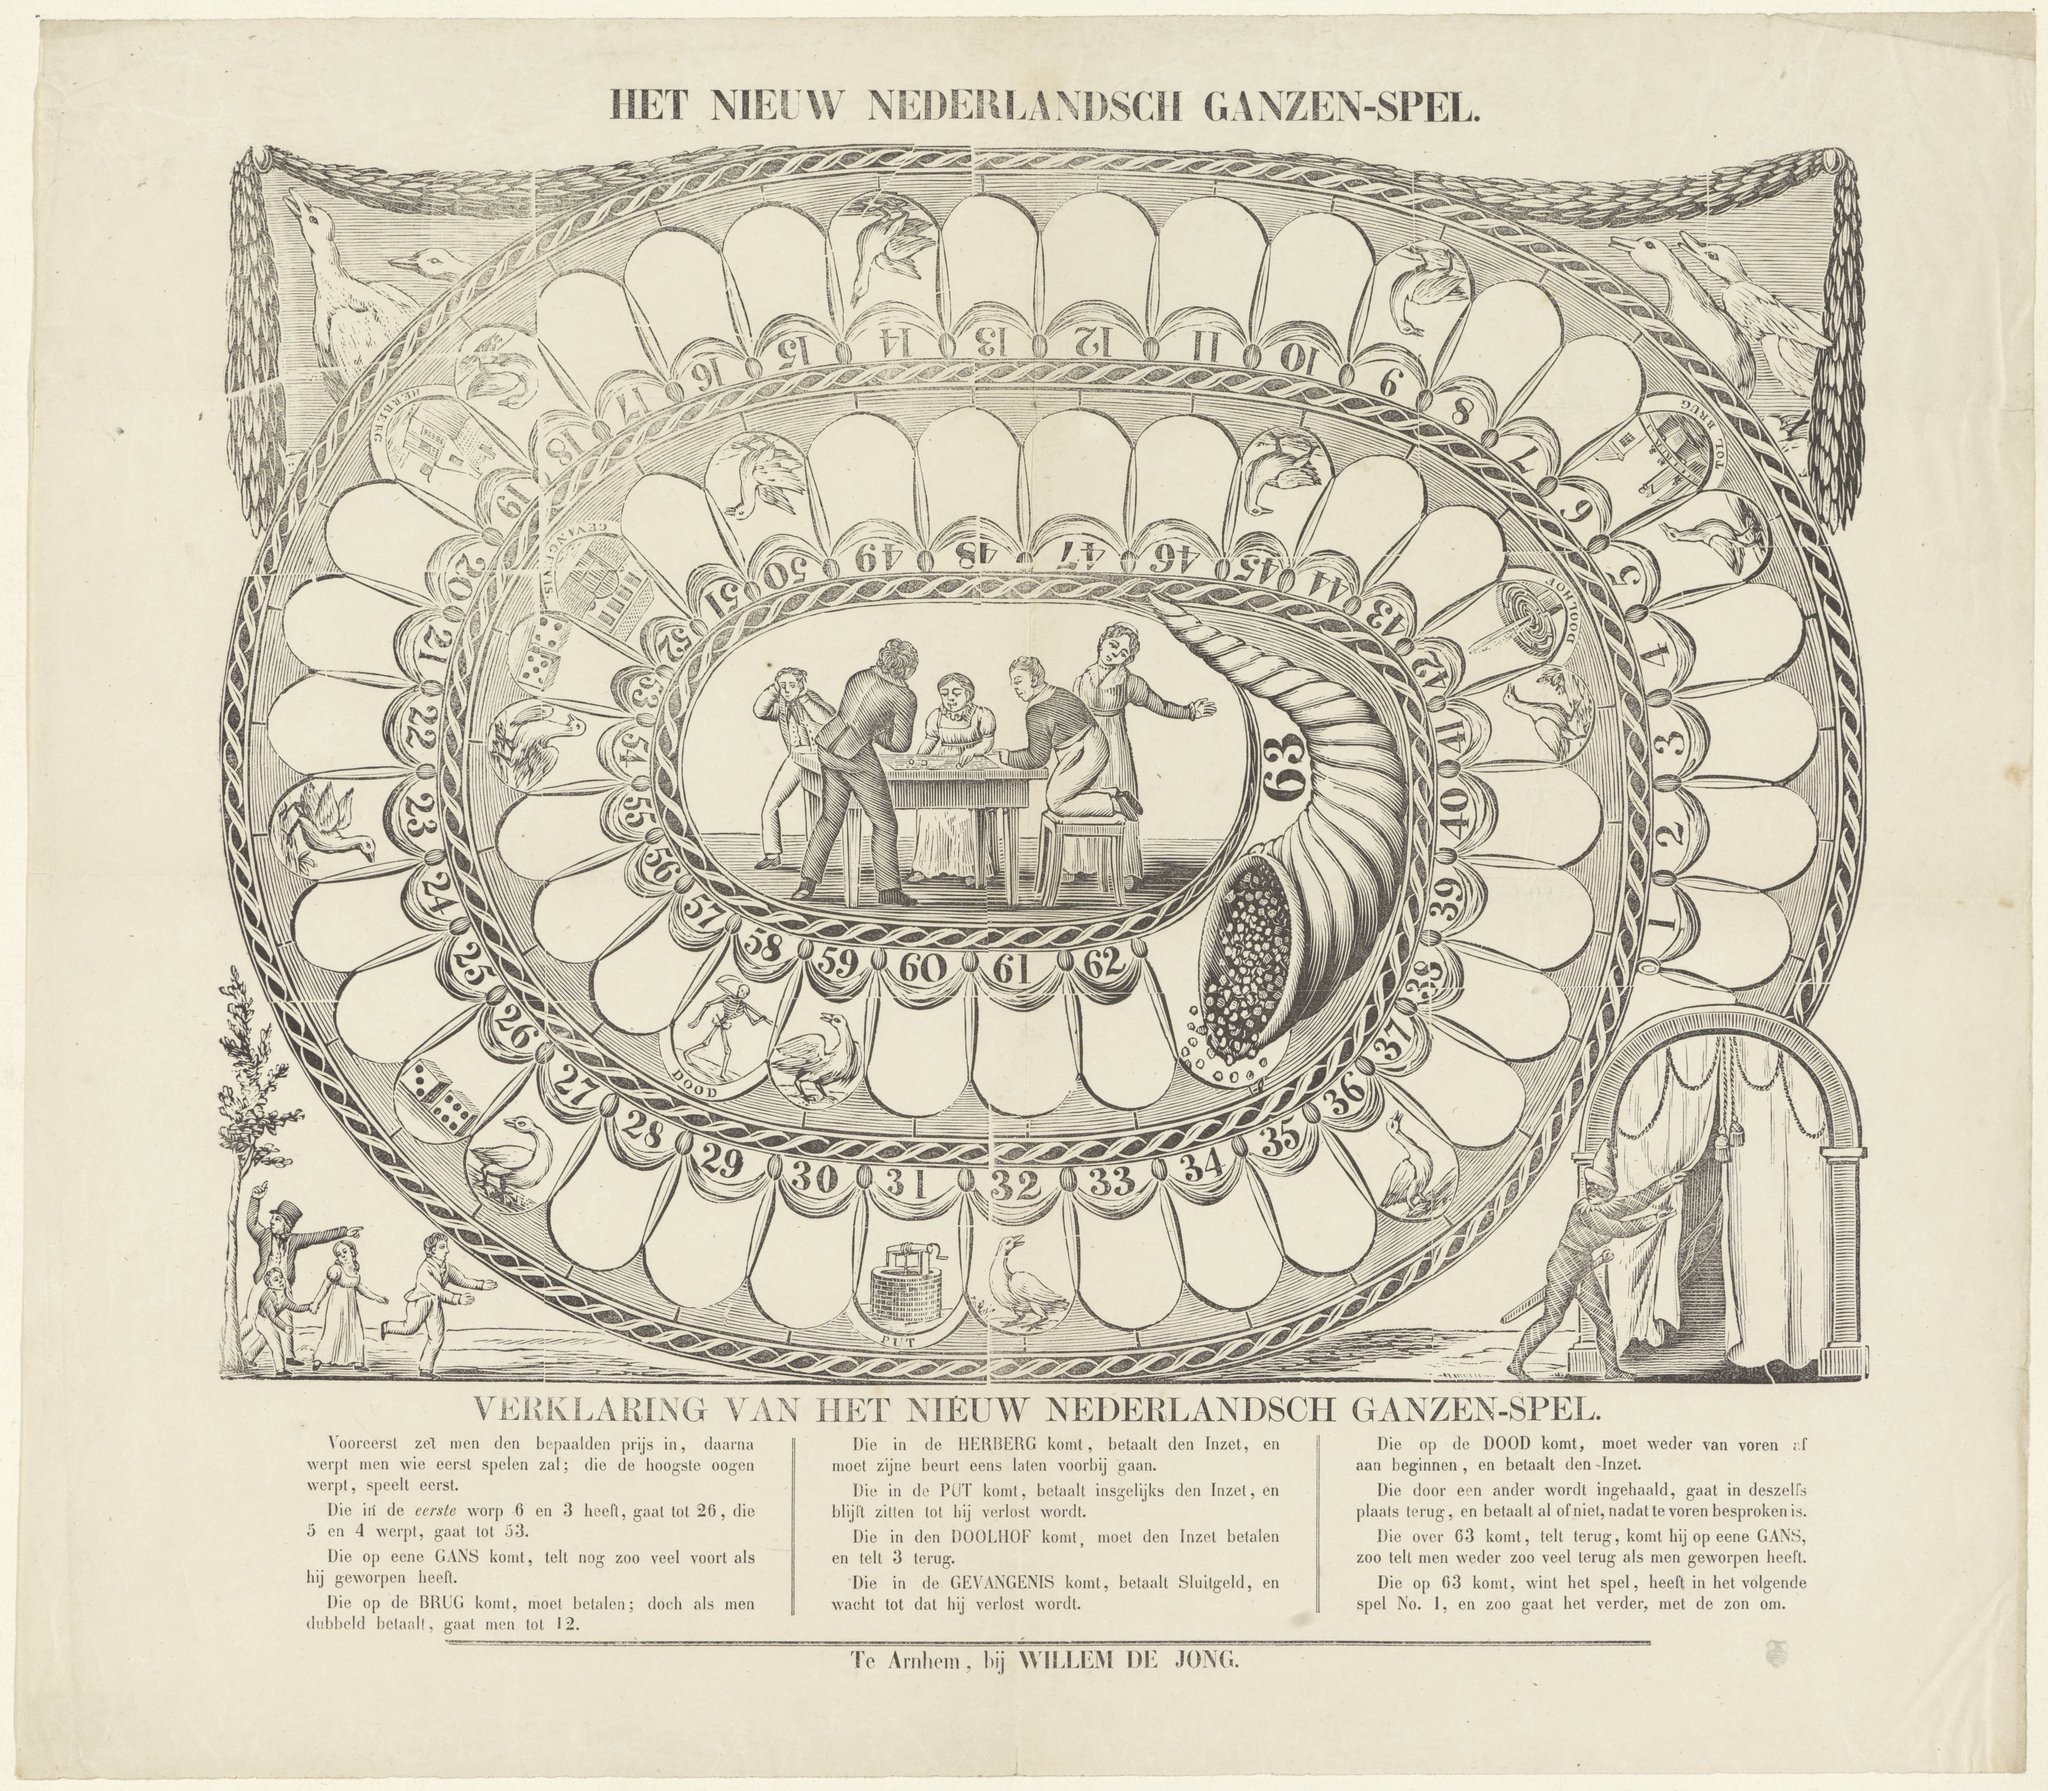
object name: game of goose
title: Het nieuw Nederlandsch ganzen-spel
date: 1874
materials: paper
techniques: letterpress printing, lithograph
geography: arnhem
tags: goose-game, children's games and plays, board-games of chance, board-games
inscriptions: collector's mark: Lugt 2760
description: Ganzenbordspel met vakjes in een spiraal, genummerd van 1 tot en met 63. Op het middenveld een voorstelling van een groep kinderen staand rond een tafel die een spelletje ganzenbord speelt. In de hoeken kinderen, harlekijn en ganzen. In de ondermarge de spelregels in drie kolommen. Boven de titel.